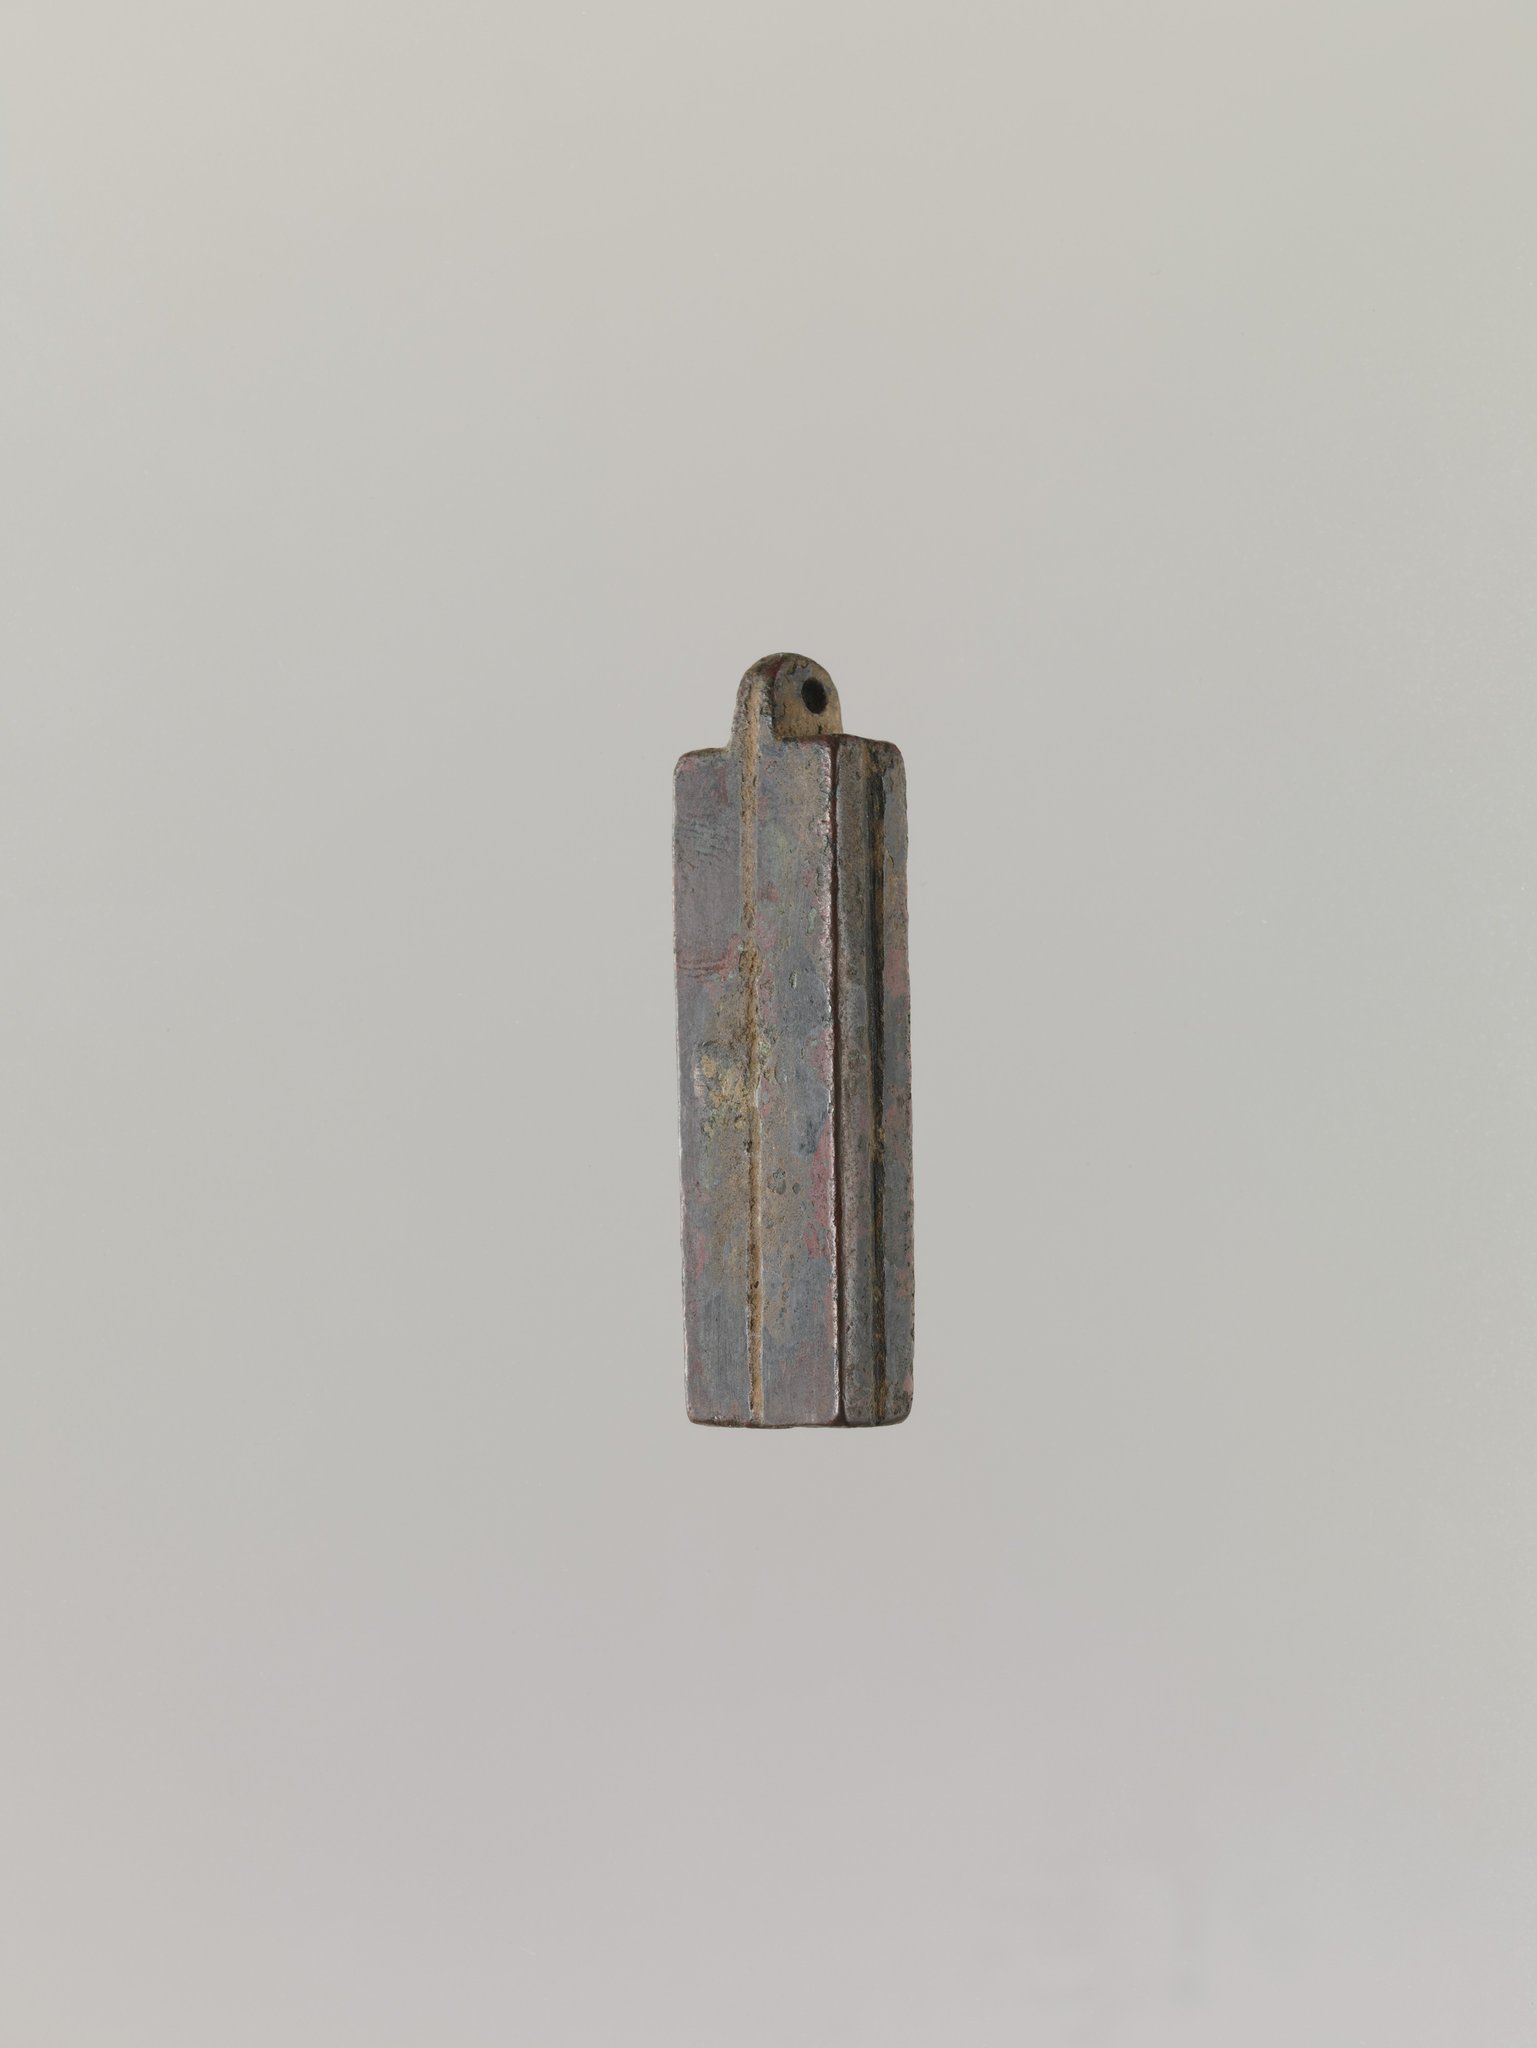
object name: coin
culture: chinese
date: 206 BCE-220 CE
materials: bronze